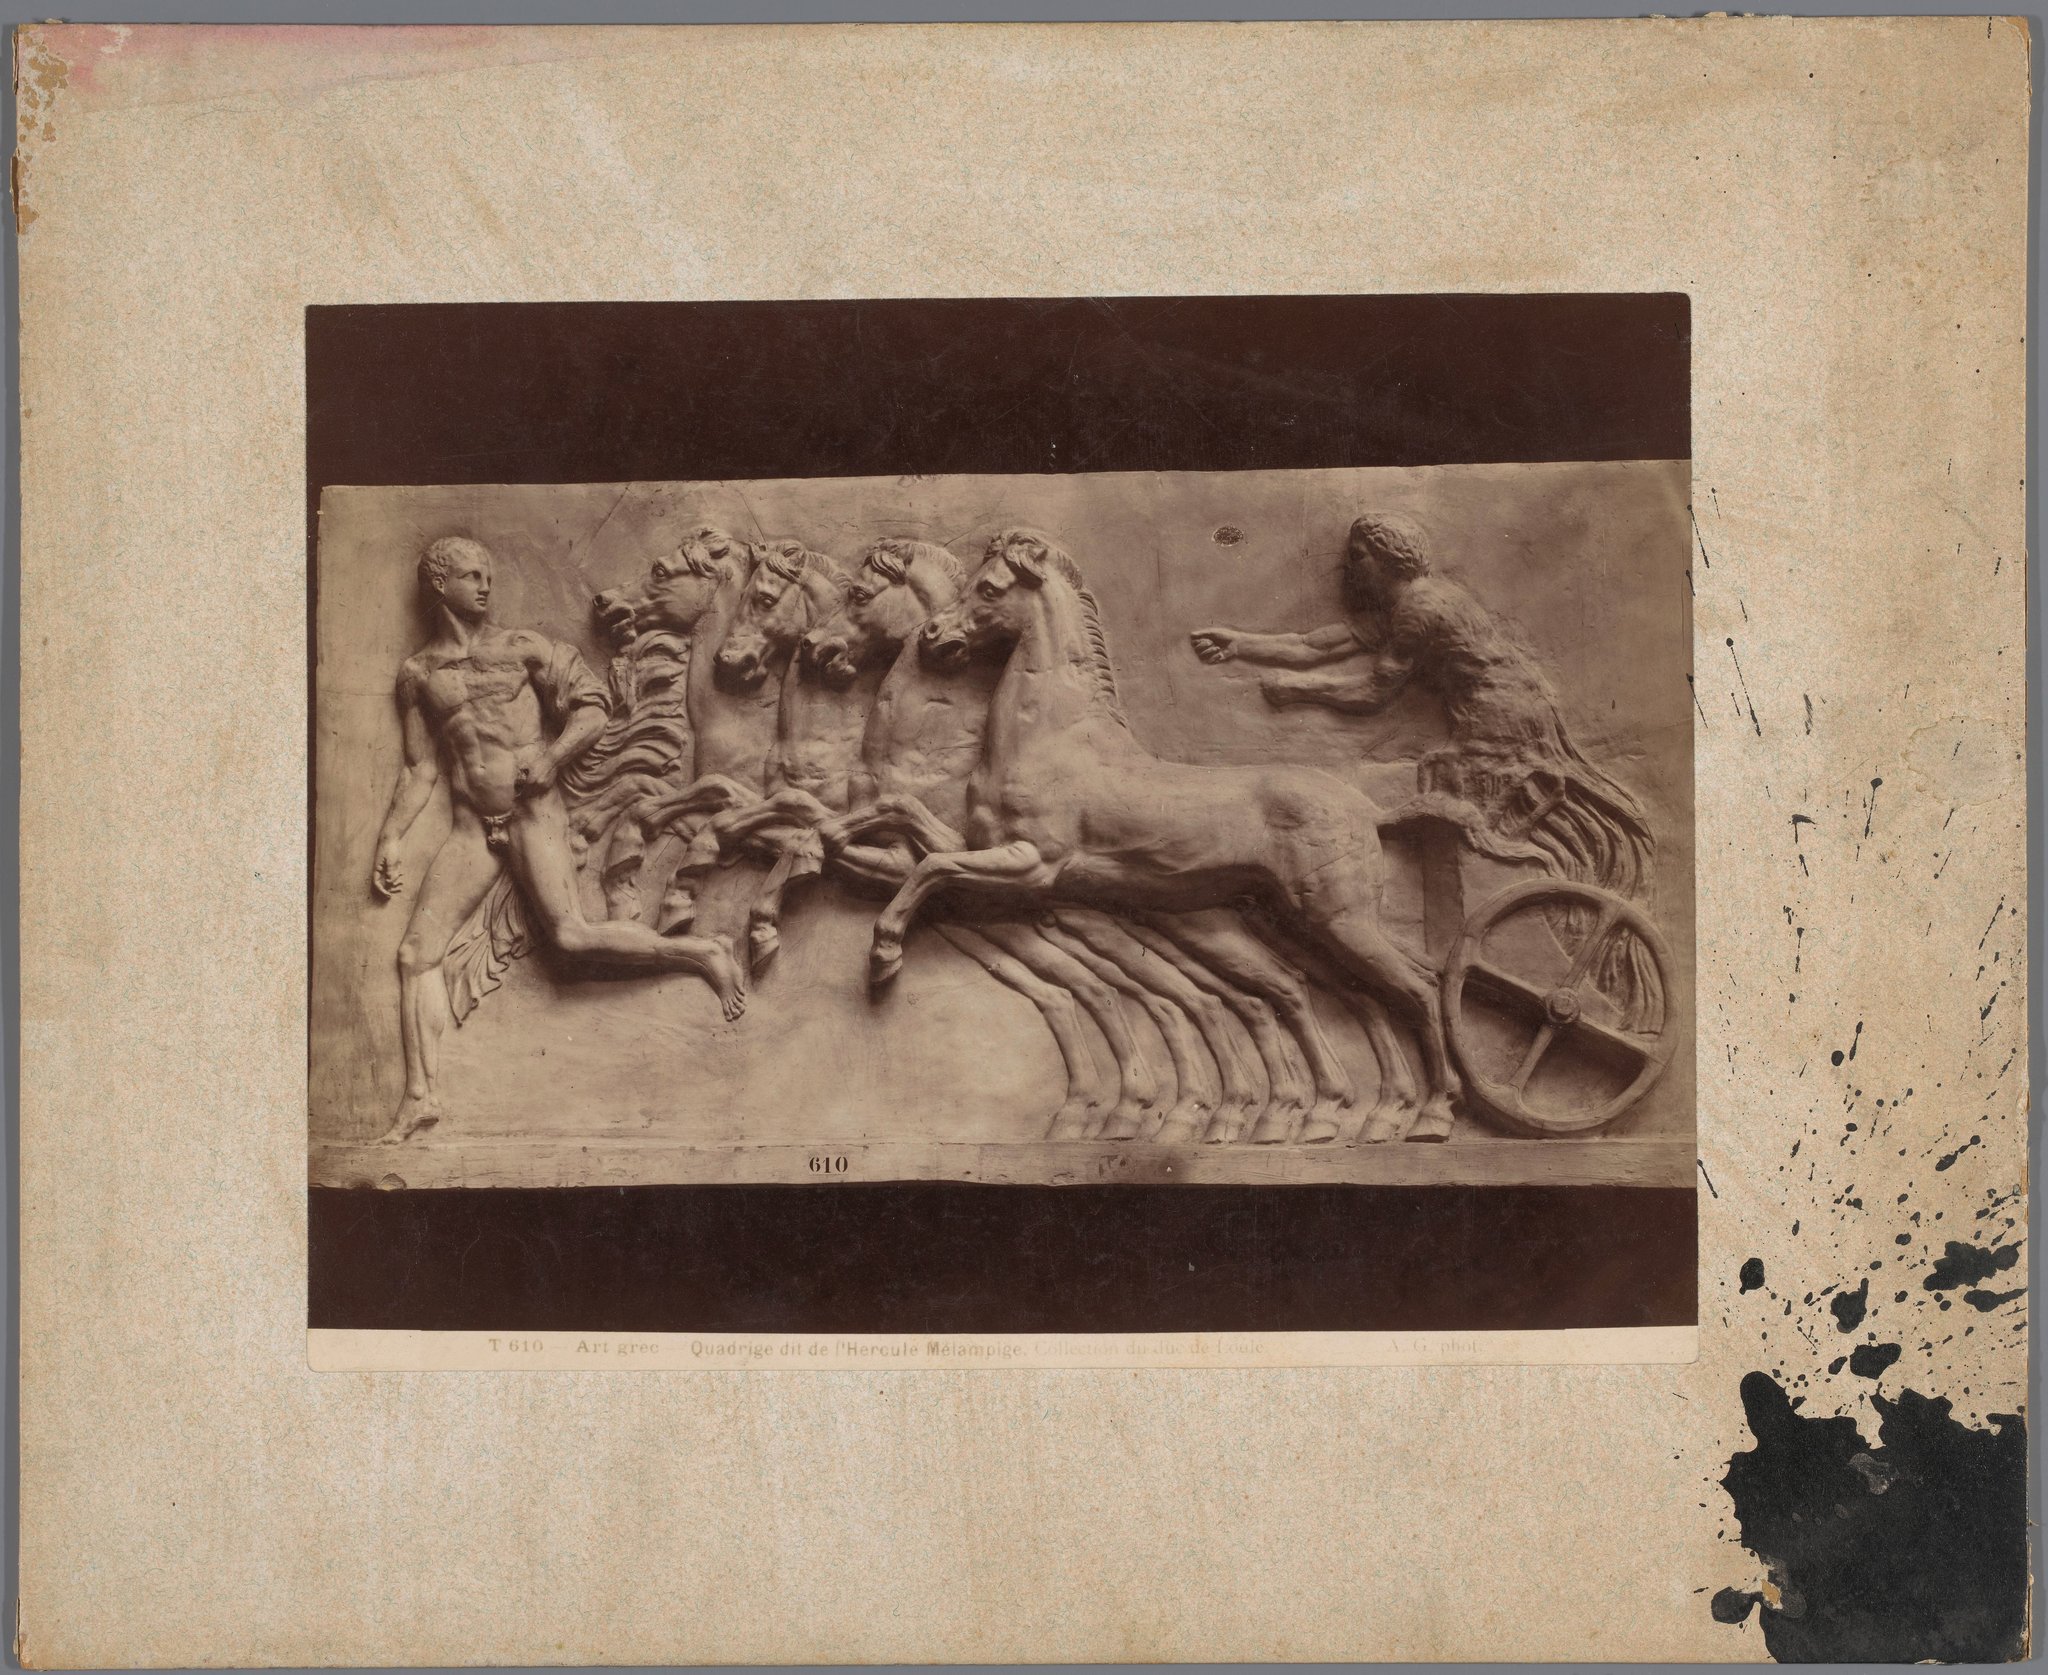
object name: photograph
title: Art Grec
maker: Anonymous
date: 1850-1900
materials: cardboard, photographic support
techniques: albumen print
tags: (story of) hercules (heracles), piece of sculpture, reproduction of a piece of sculpture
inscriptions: inscription: ‘Collection de duc de Loule A.G. phot.’, number: ‘T 610’, collector's mark: ‘Rijks-normaalschool voor teekenonderwijzers amsterdam’